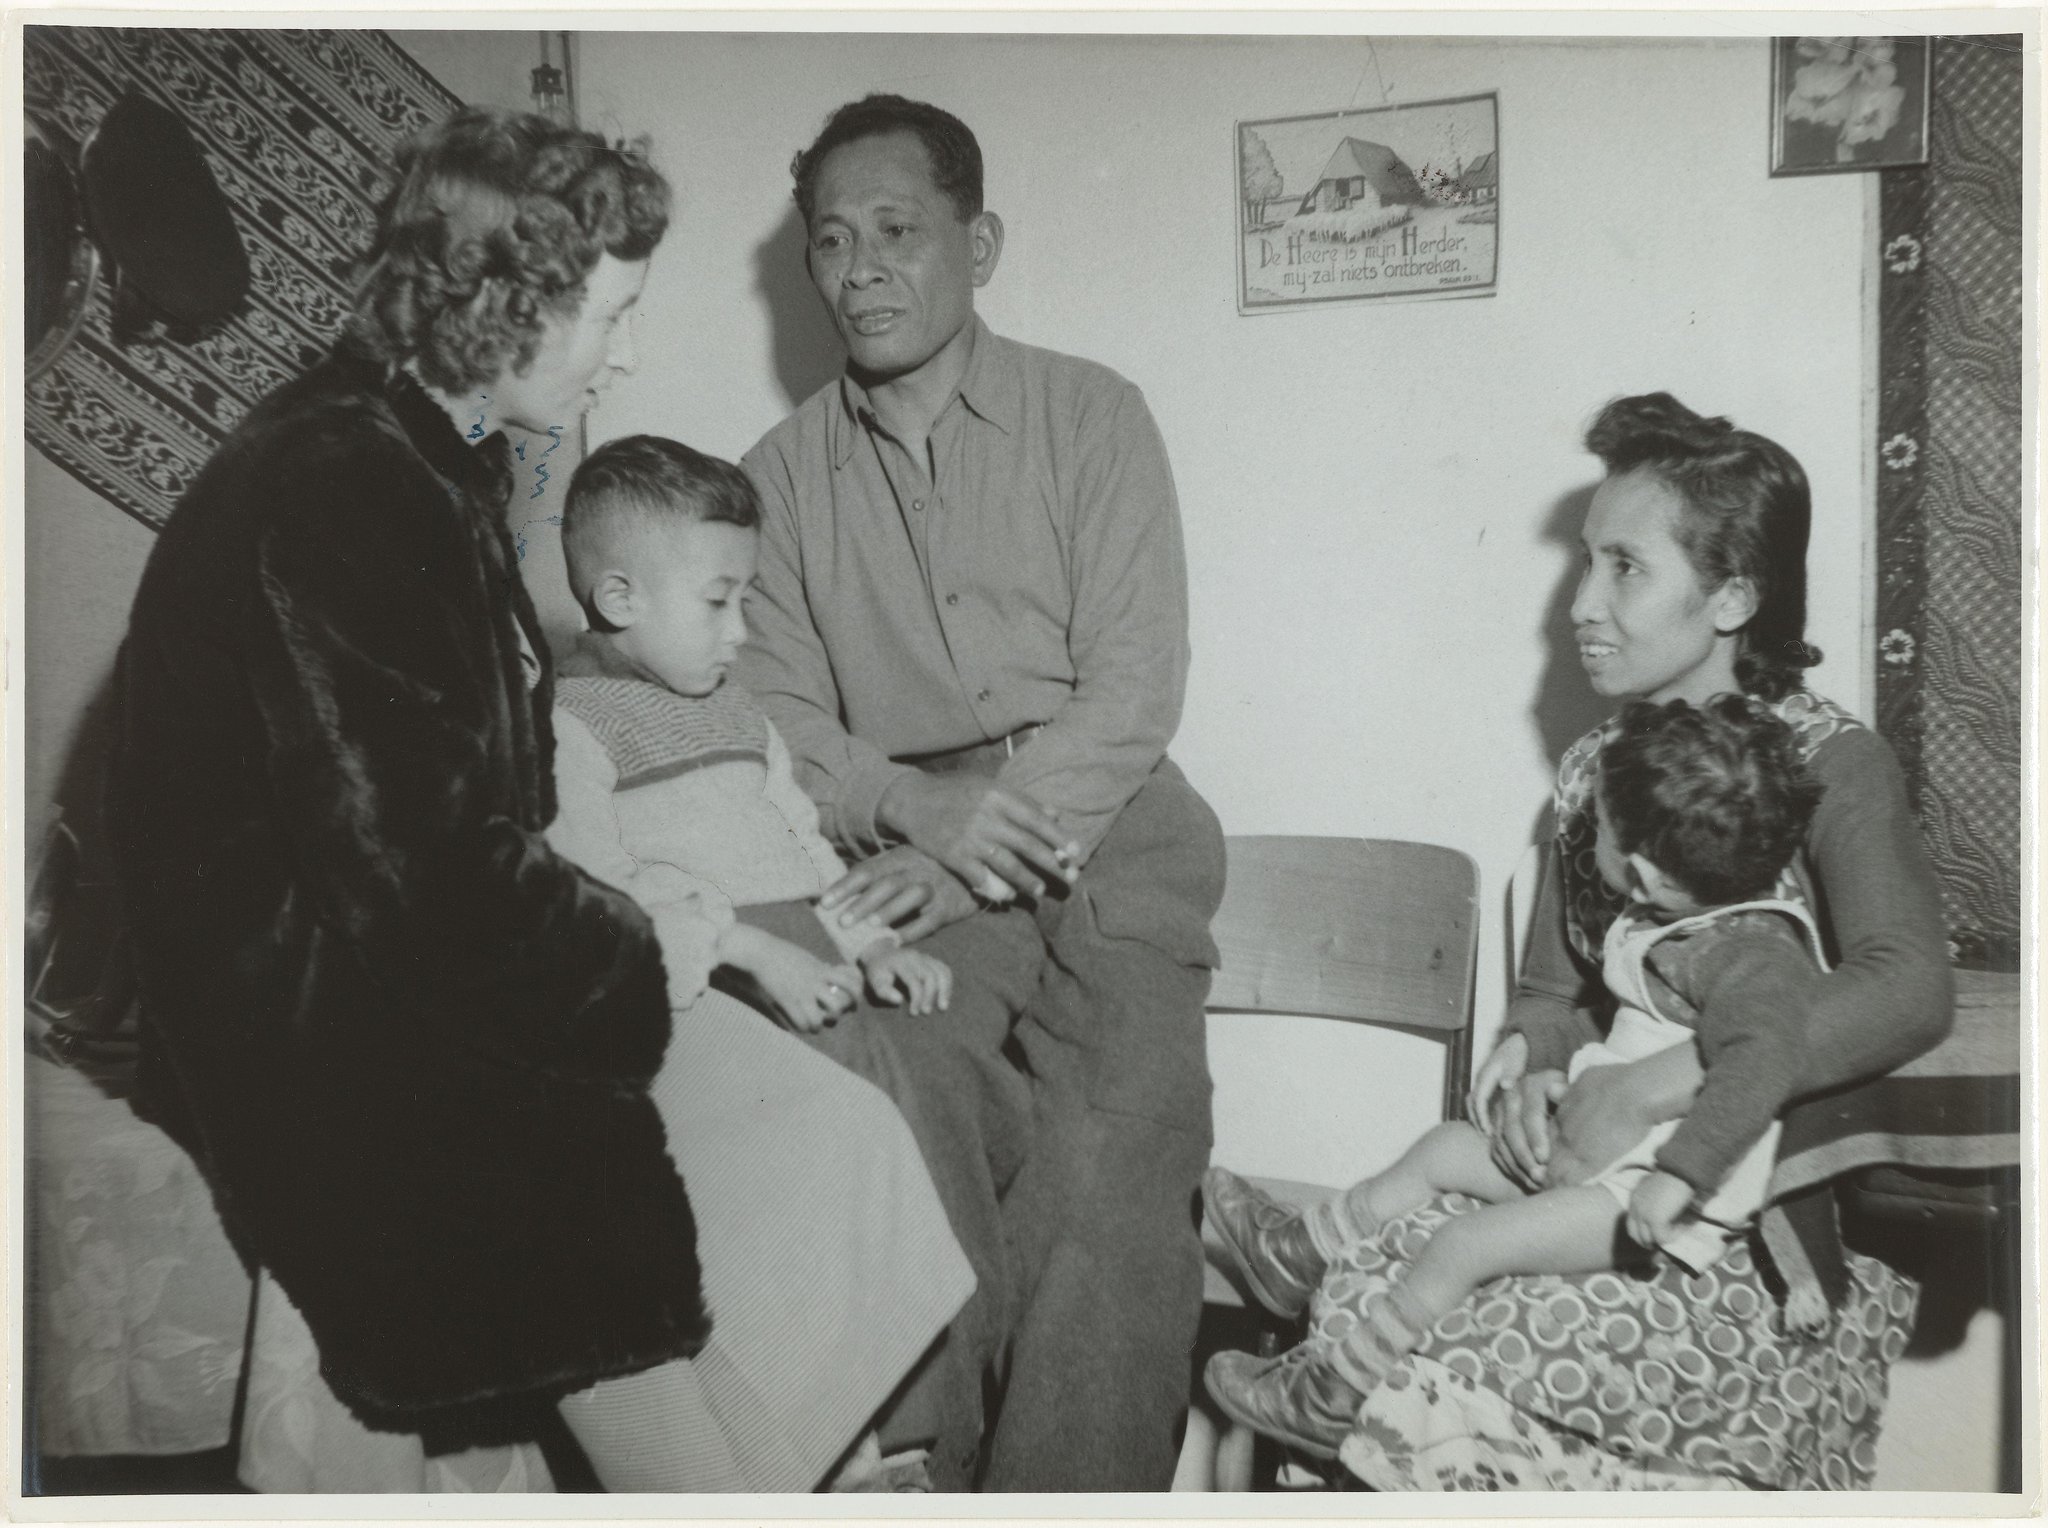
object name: photograph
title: Het gezin van ex-sergeant KNSL J. Wisupuny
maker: e. de vries (fotograaf)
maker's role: fotograaf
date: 1951-1955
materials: photographic support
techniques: photography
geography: netherlands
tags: netherlands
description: Een Ambonees gezin, ouders en twee kinderen, in gesprek met een Nederlandse vrouw. Met tekst op achterzijde.